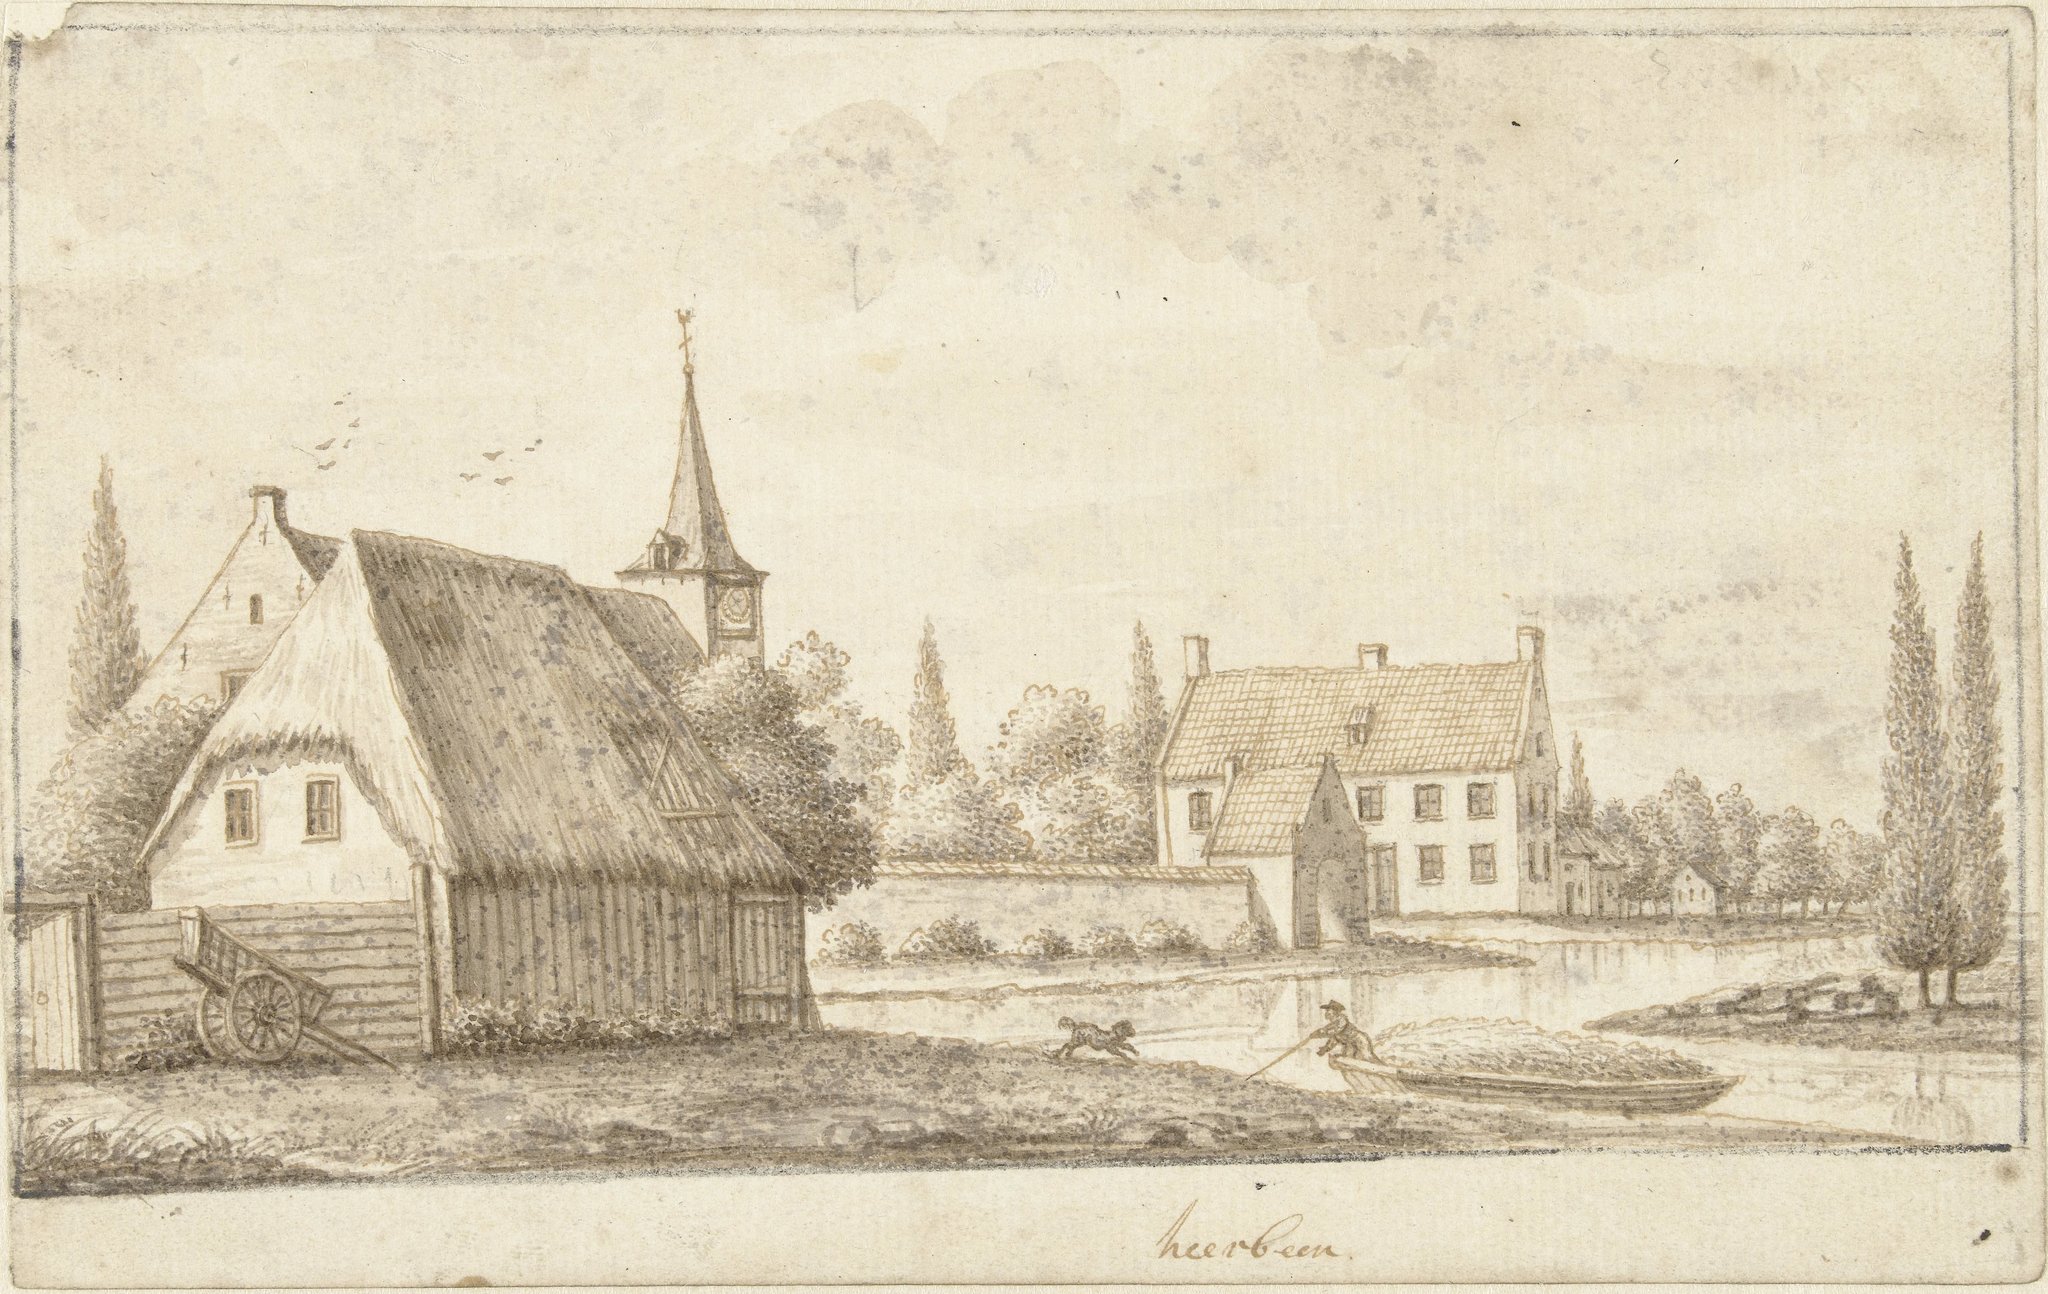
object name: drawing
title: Het dorp Heesbeen bij Heusden, Noord Brabant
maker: joseph adolf schmetterling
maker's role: draughtsman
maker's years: 1751-1828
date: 1761-1828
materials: ink, paper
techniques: brush, pen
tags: founding a village